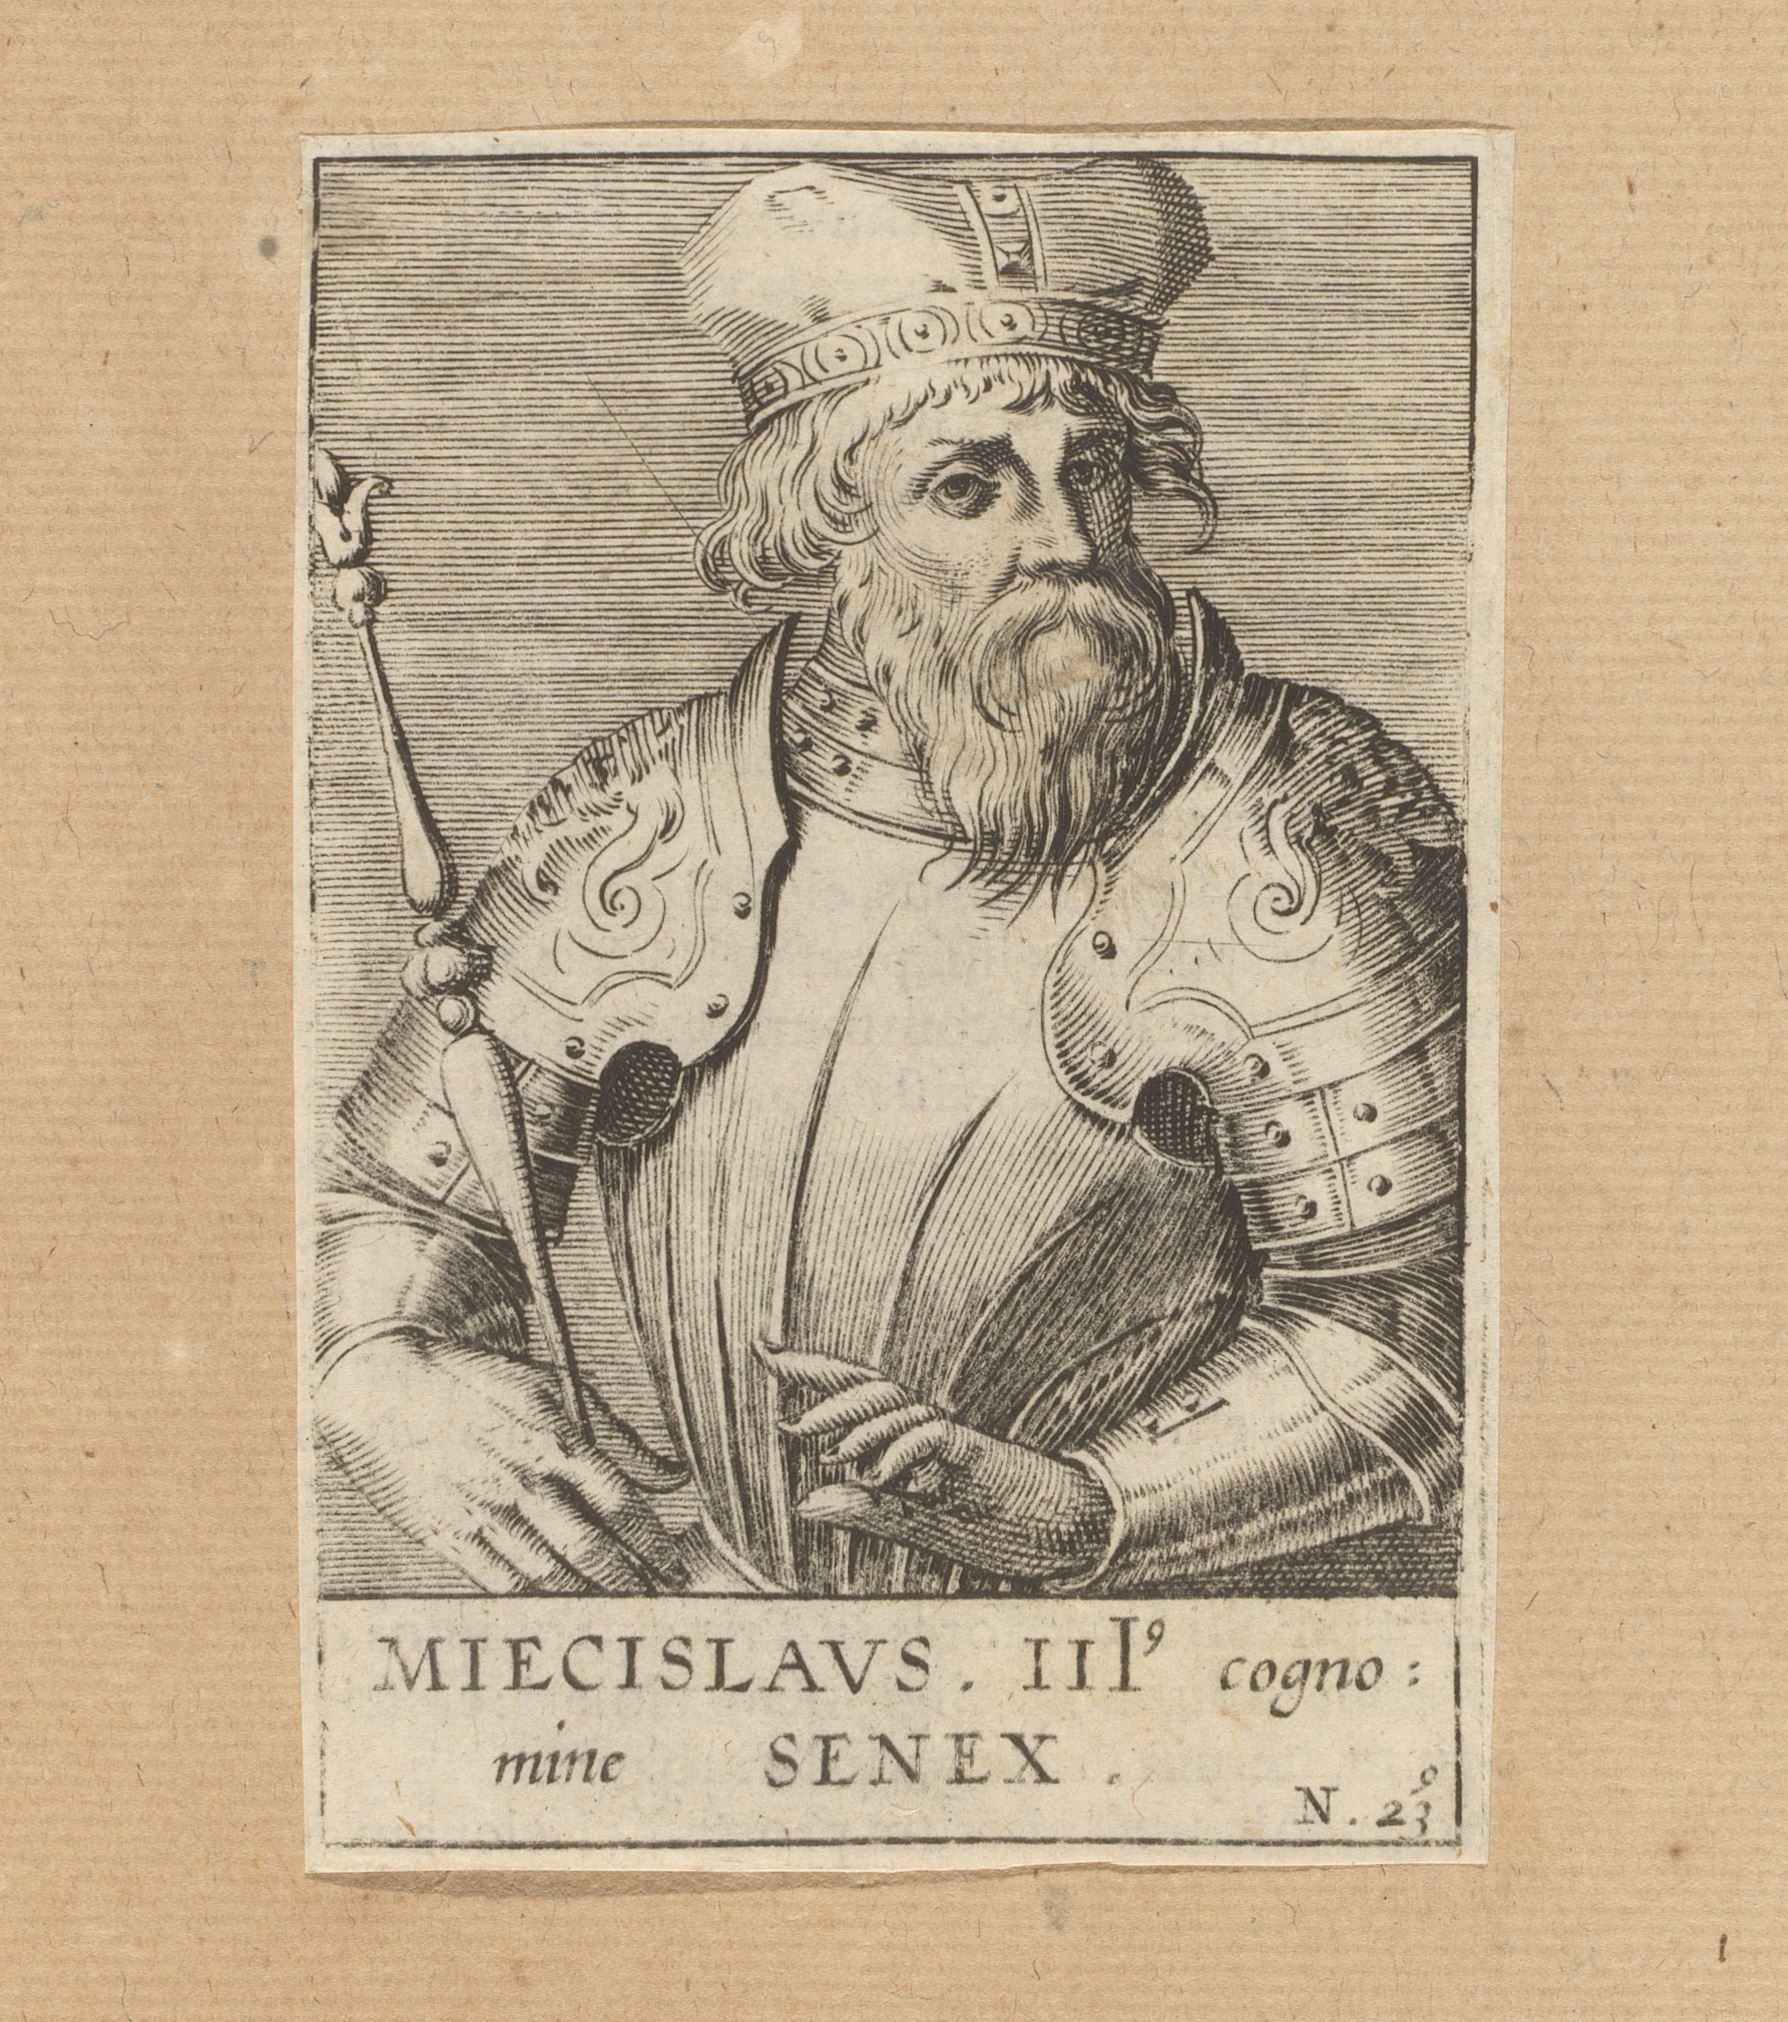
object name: book illustration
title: Portret van Mieszko III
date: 1574-1594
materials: paper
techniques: woodcut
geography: cologne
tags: historical persons, ruler, sovereign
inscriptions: collector's mark: Lugt 240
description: Prent gebruikt in: Mylius, Arnold. Principum et Regum Polonorum Imagines ad Vivum Expressae (...). Keulen: Gottfried von Kempen, 1594.